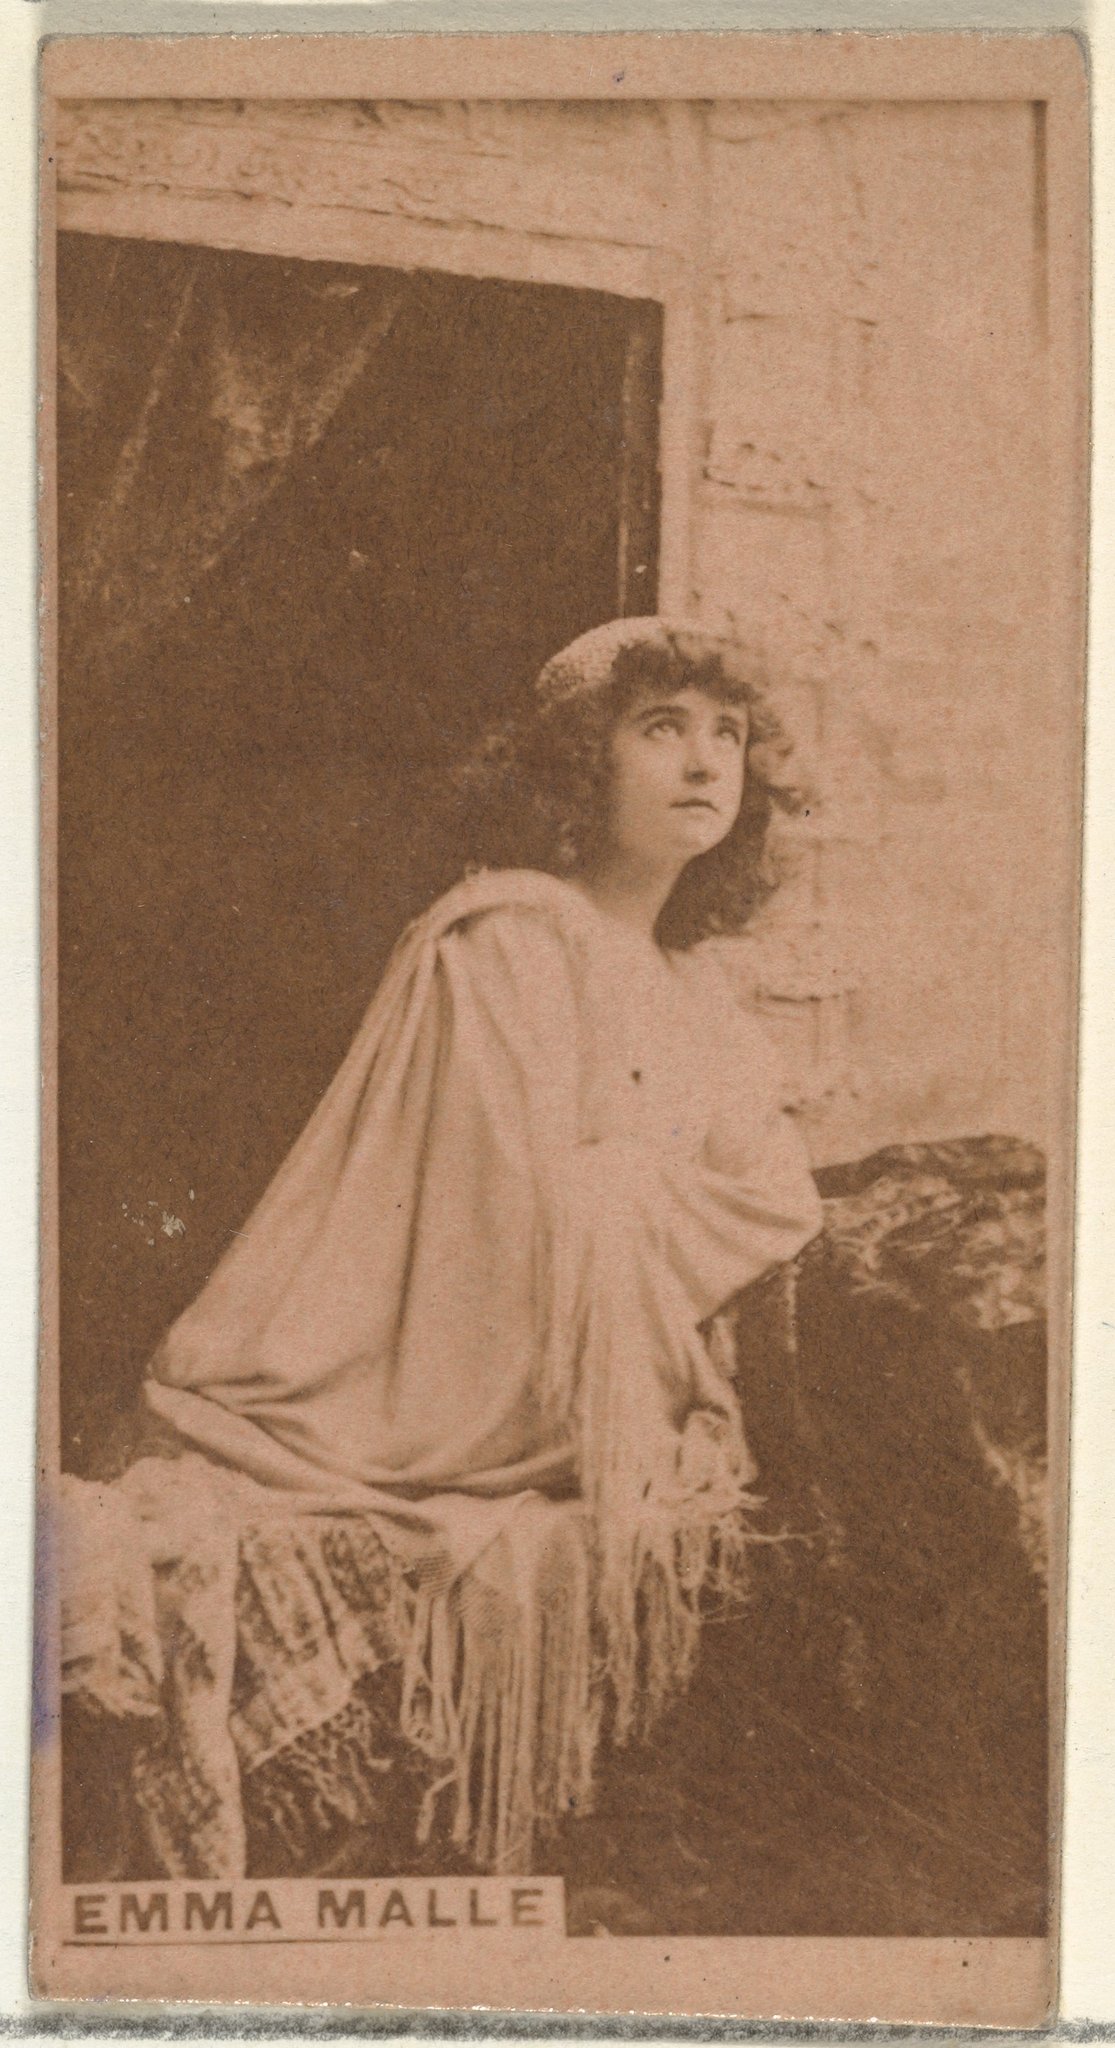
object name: photograph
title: Emma Malle, from the Actors and Actresses series (N145-8) issued by Duke Sons & Co. to promote Duke Cigarettes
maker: w. duke, sons & co.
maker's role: publisher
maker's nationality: american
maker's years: 1870-1920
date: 1891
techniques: albumen silver print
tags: portraits,women,actresses